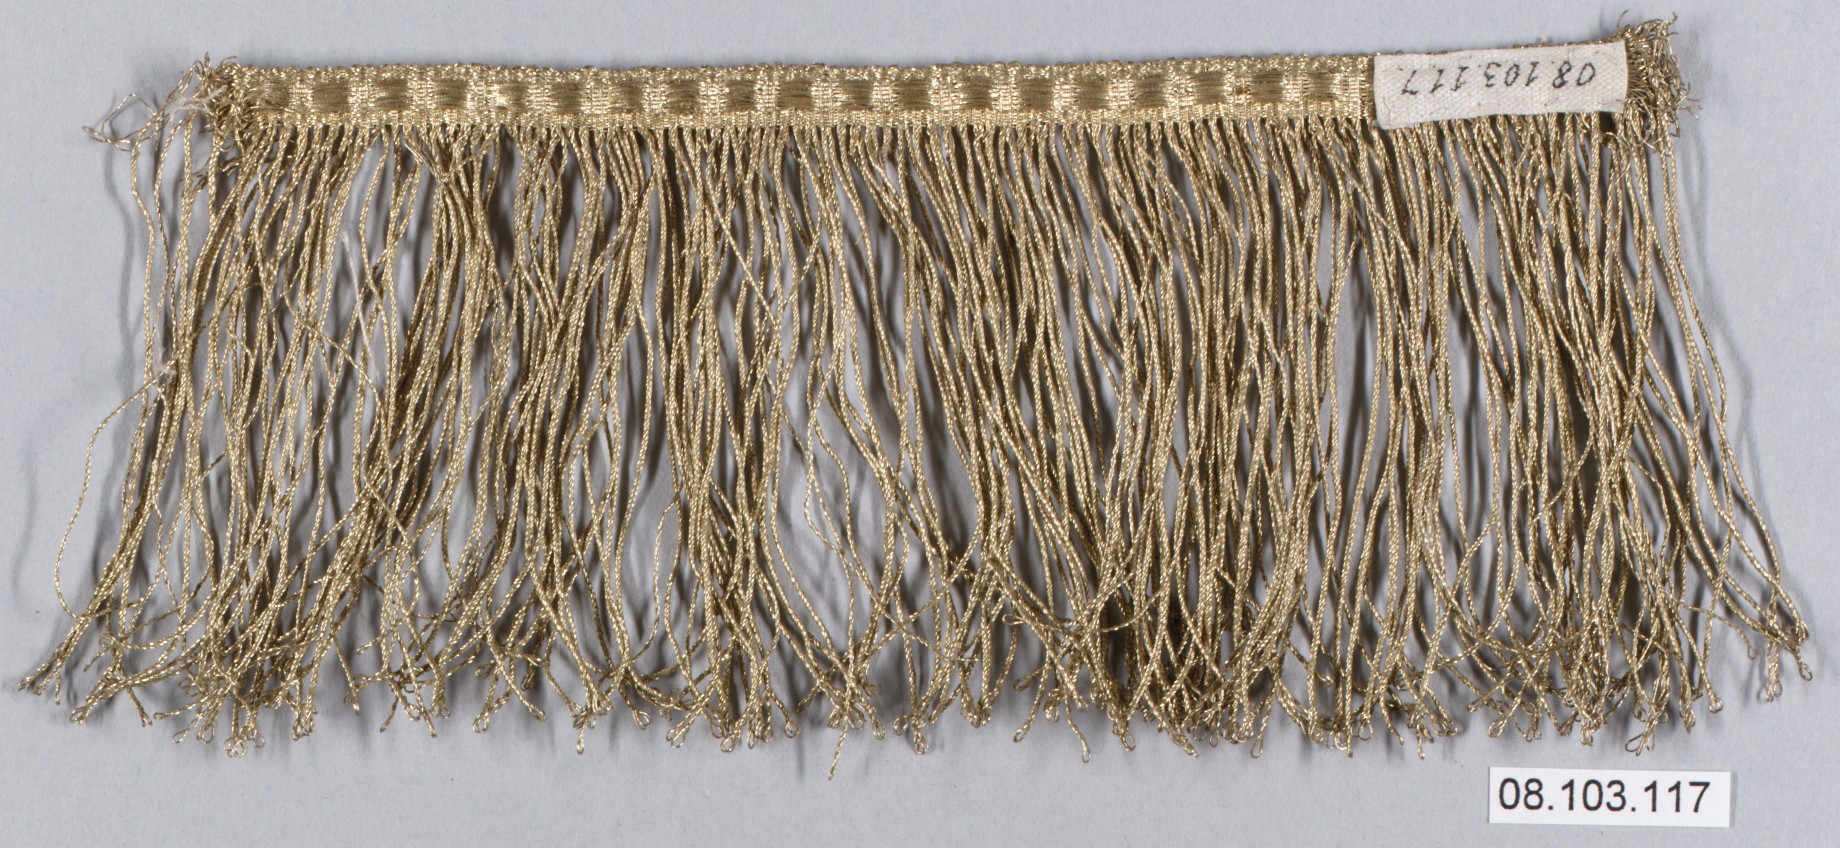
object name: fringe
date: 1801-1833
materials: metal thread